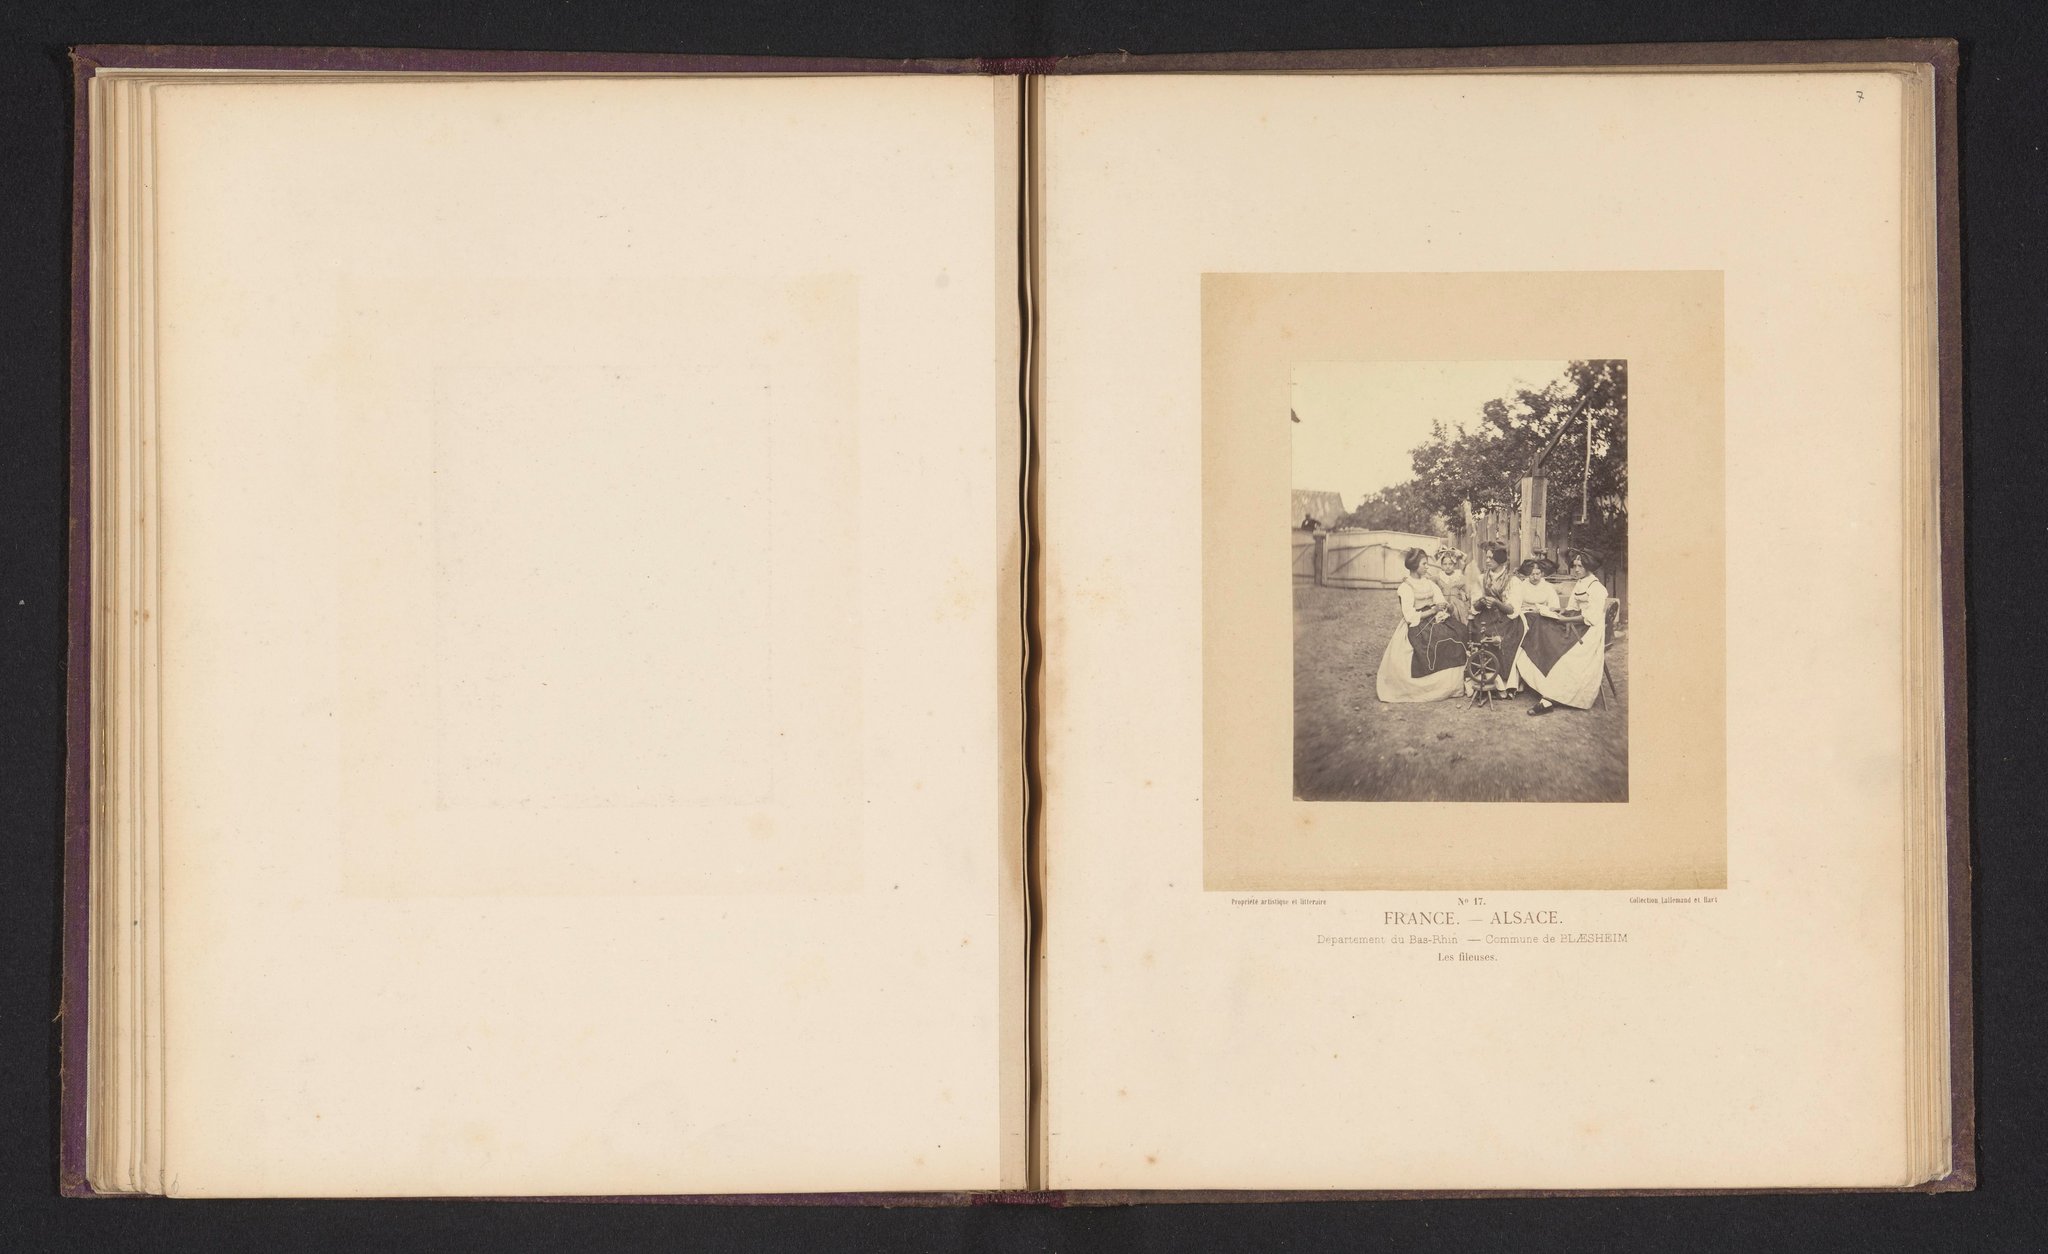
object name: page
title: Spinnende vrouwen in klederdracht te Blaesheim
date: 1855-1865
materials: photographic support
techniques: albumen print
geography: blaesheim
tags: adolescent, young woman, maiden, spinning-wheel, folk costume, regional costume, spinning (manufacture of yarn)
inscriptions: number: ‘No. 17.’, inscription: ‘France. Alsace. Departement du Bas-Rhin.- Commune de Blaesheim’, number: ‘7’